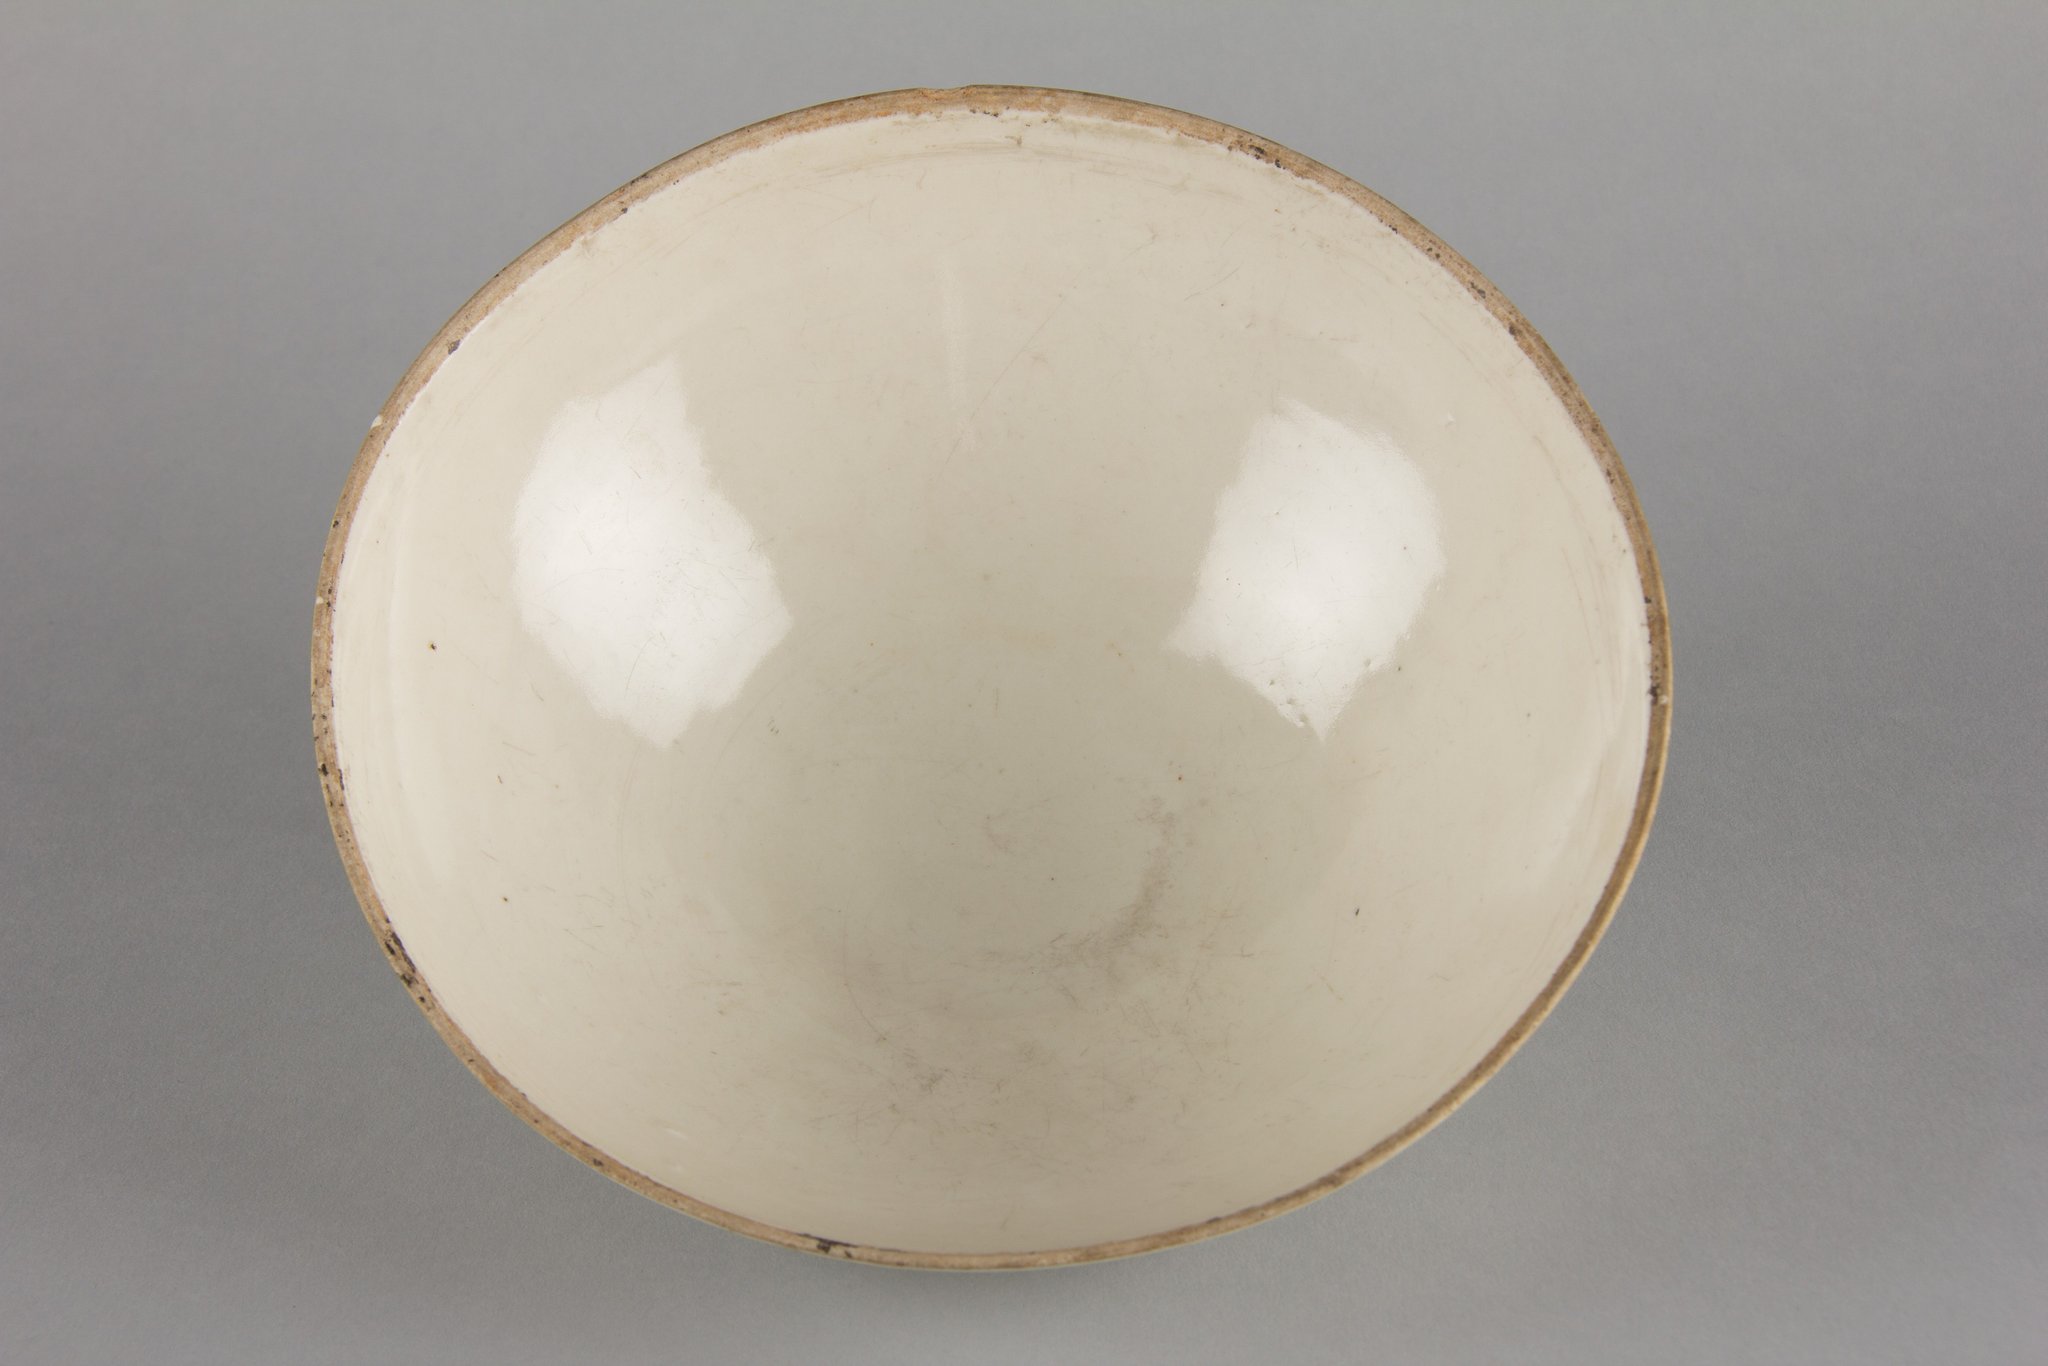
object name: bowl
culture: chinese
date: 1101-1300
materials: glaze, porcelain